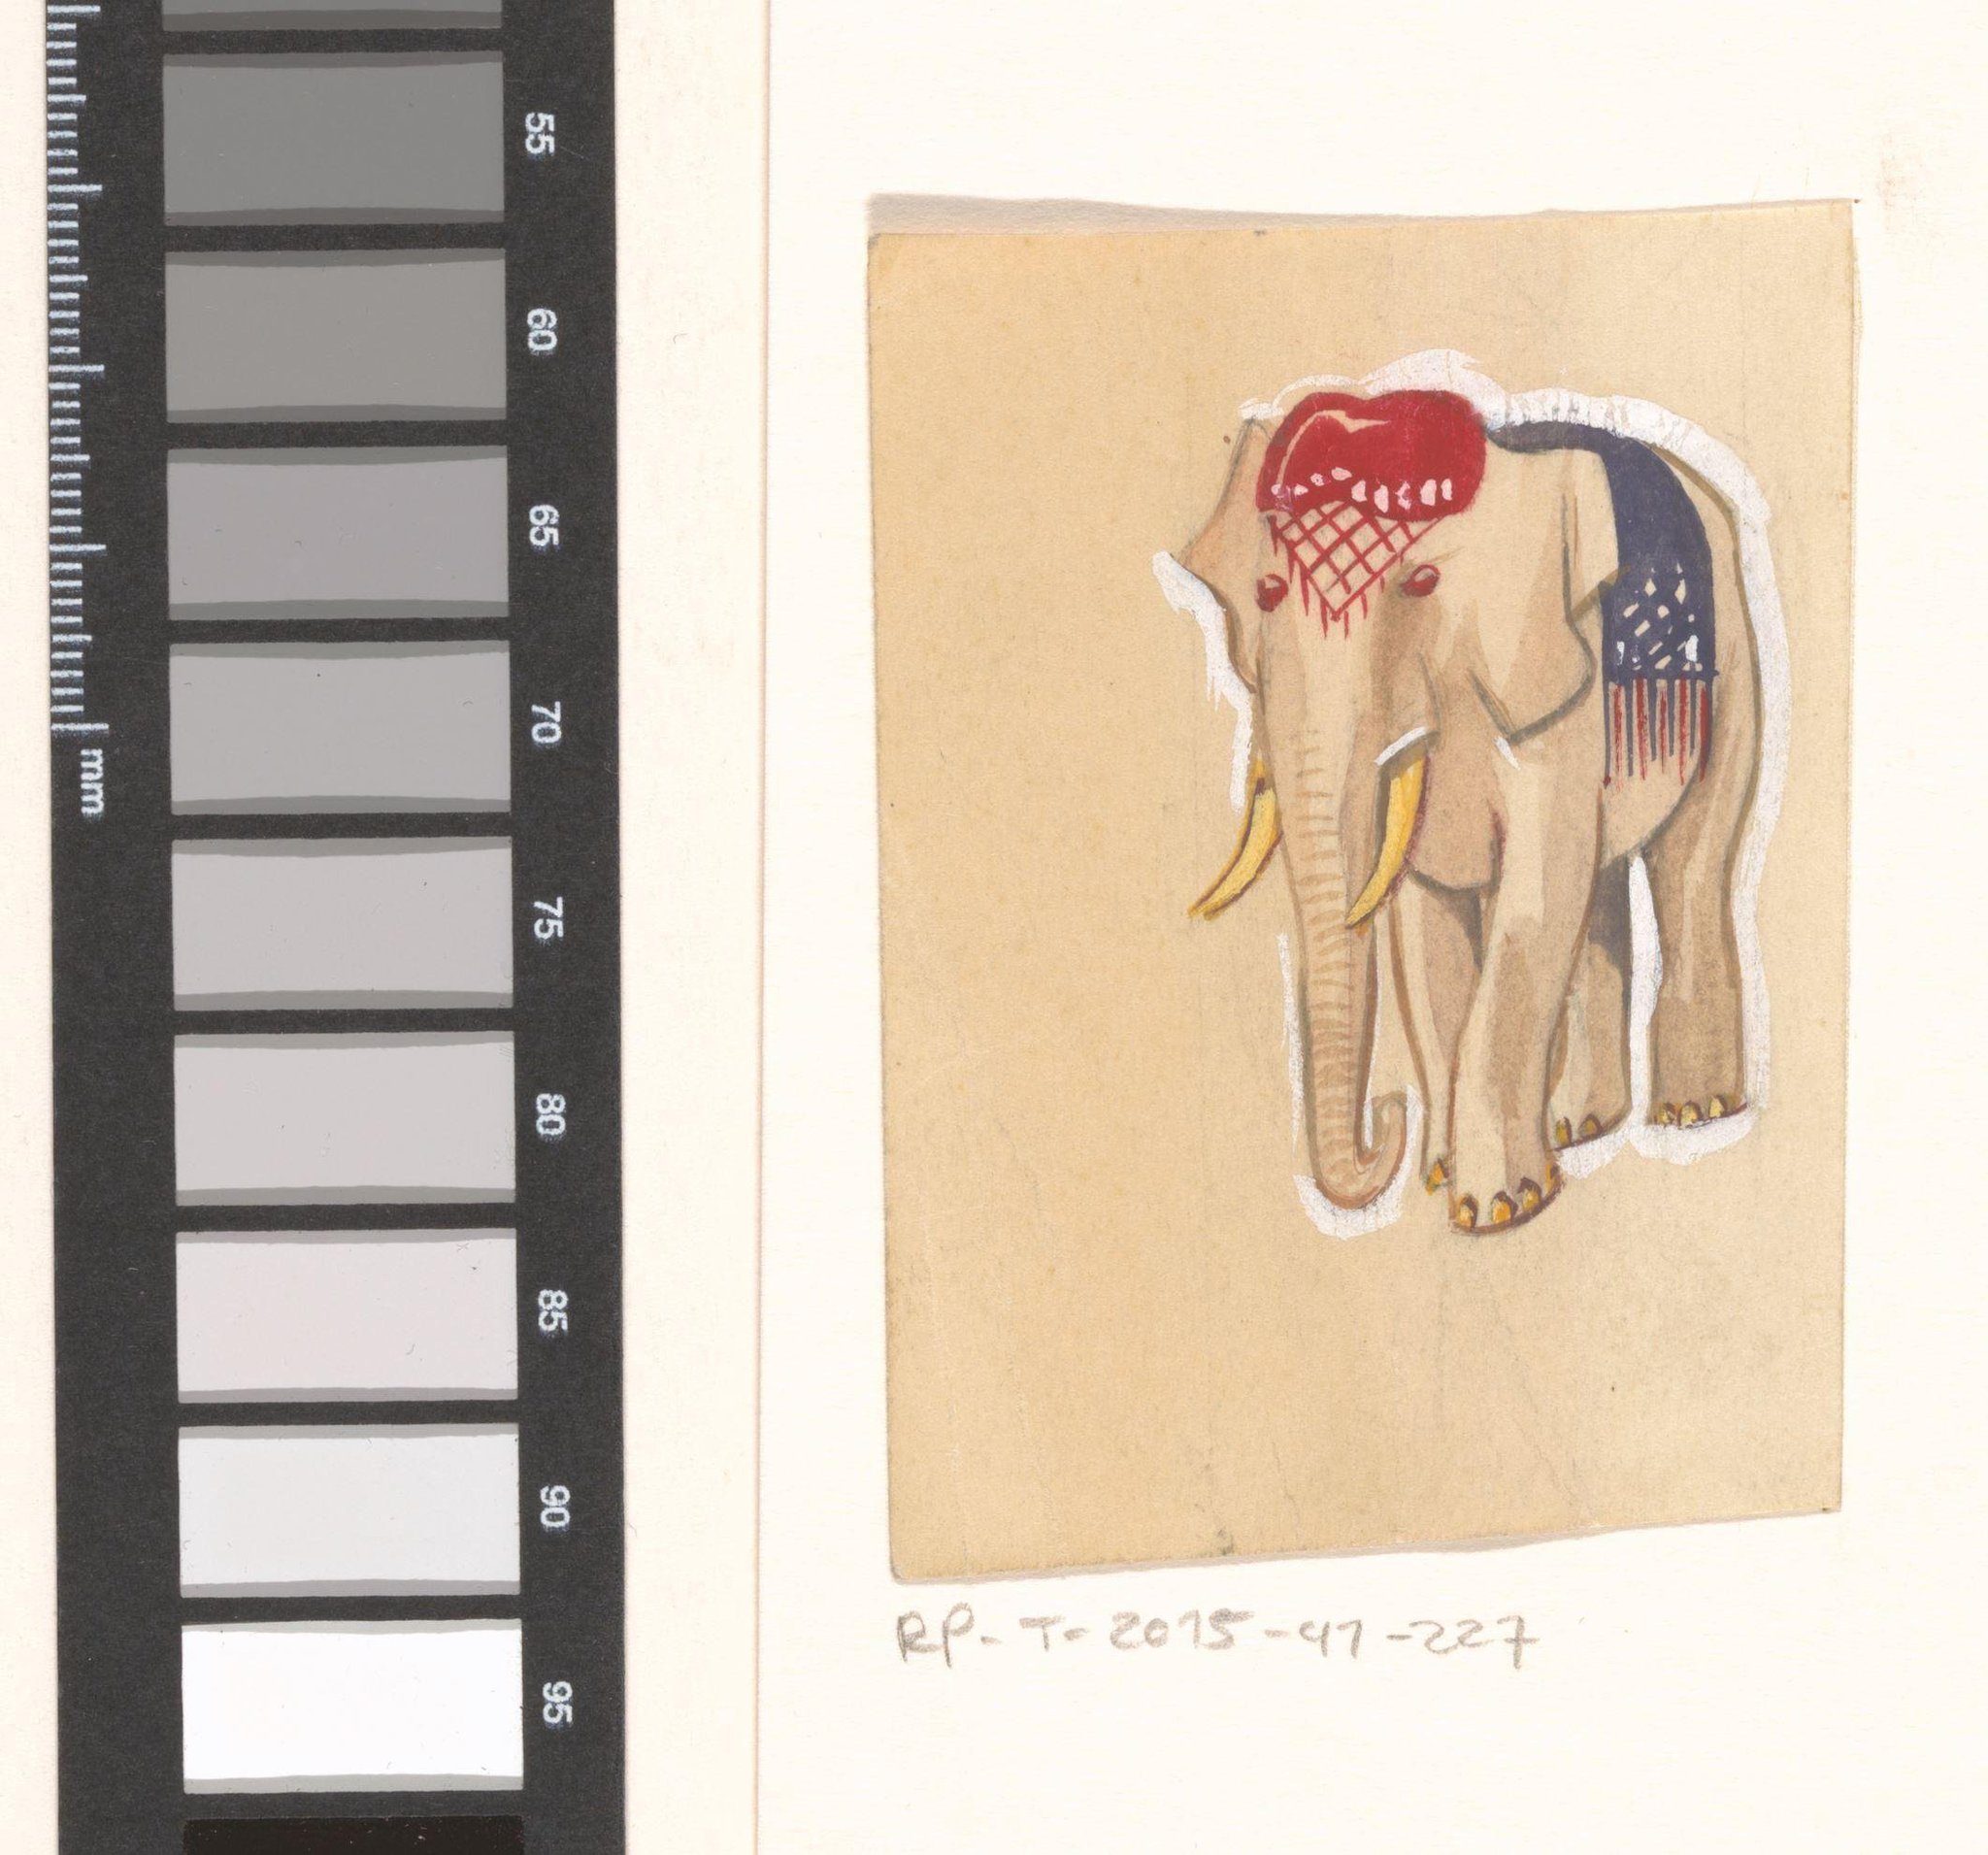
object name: boekillustratie ontwerp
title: Versierde olifant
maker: hans borrebach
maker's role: draughtsman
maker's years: 1903-1991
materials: paint, paper, pencil, watercolor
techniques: brush, pen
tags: trunked animals: elephant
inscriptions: collector's mark: Lugt 2228a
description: Ontwerp voor: Borrebach, Hans. Een hart klopt voor Pepita. Roman voor oudere meisjes. Amsterdam: Veen, 1948.